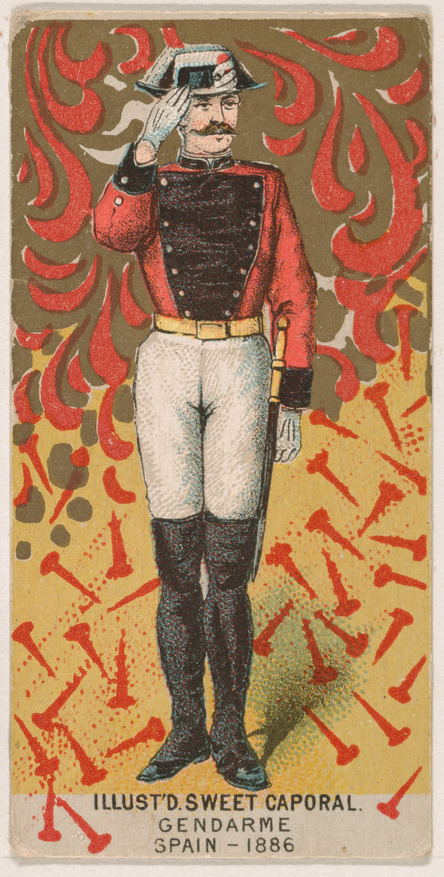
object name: print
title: Gendarme, Spain, 1886, from the Military Series (N224) issued by Kinney Tobacco Company to promote Sweet Caporal Cigarettes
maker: kinney brothers tobacco company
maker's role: publisher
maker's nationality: american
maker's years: 1869-2011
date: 1888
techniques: color lithograph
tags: military,men